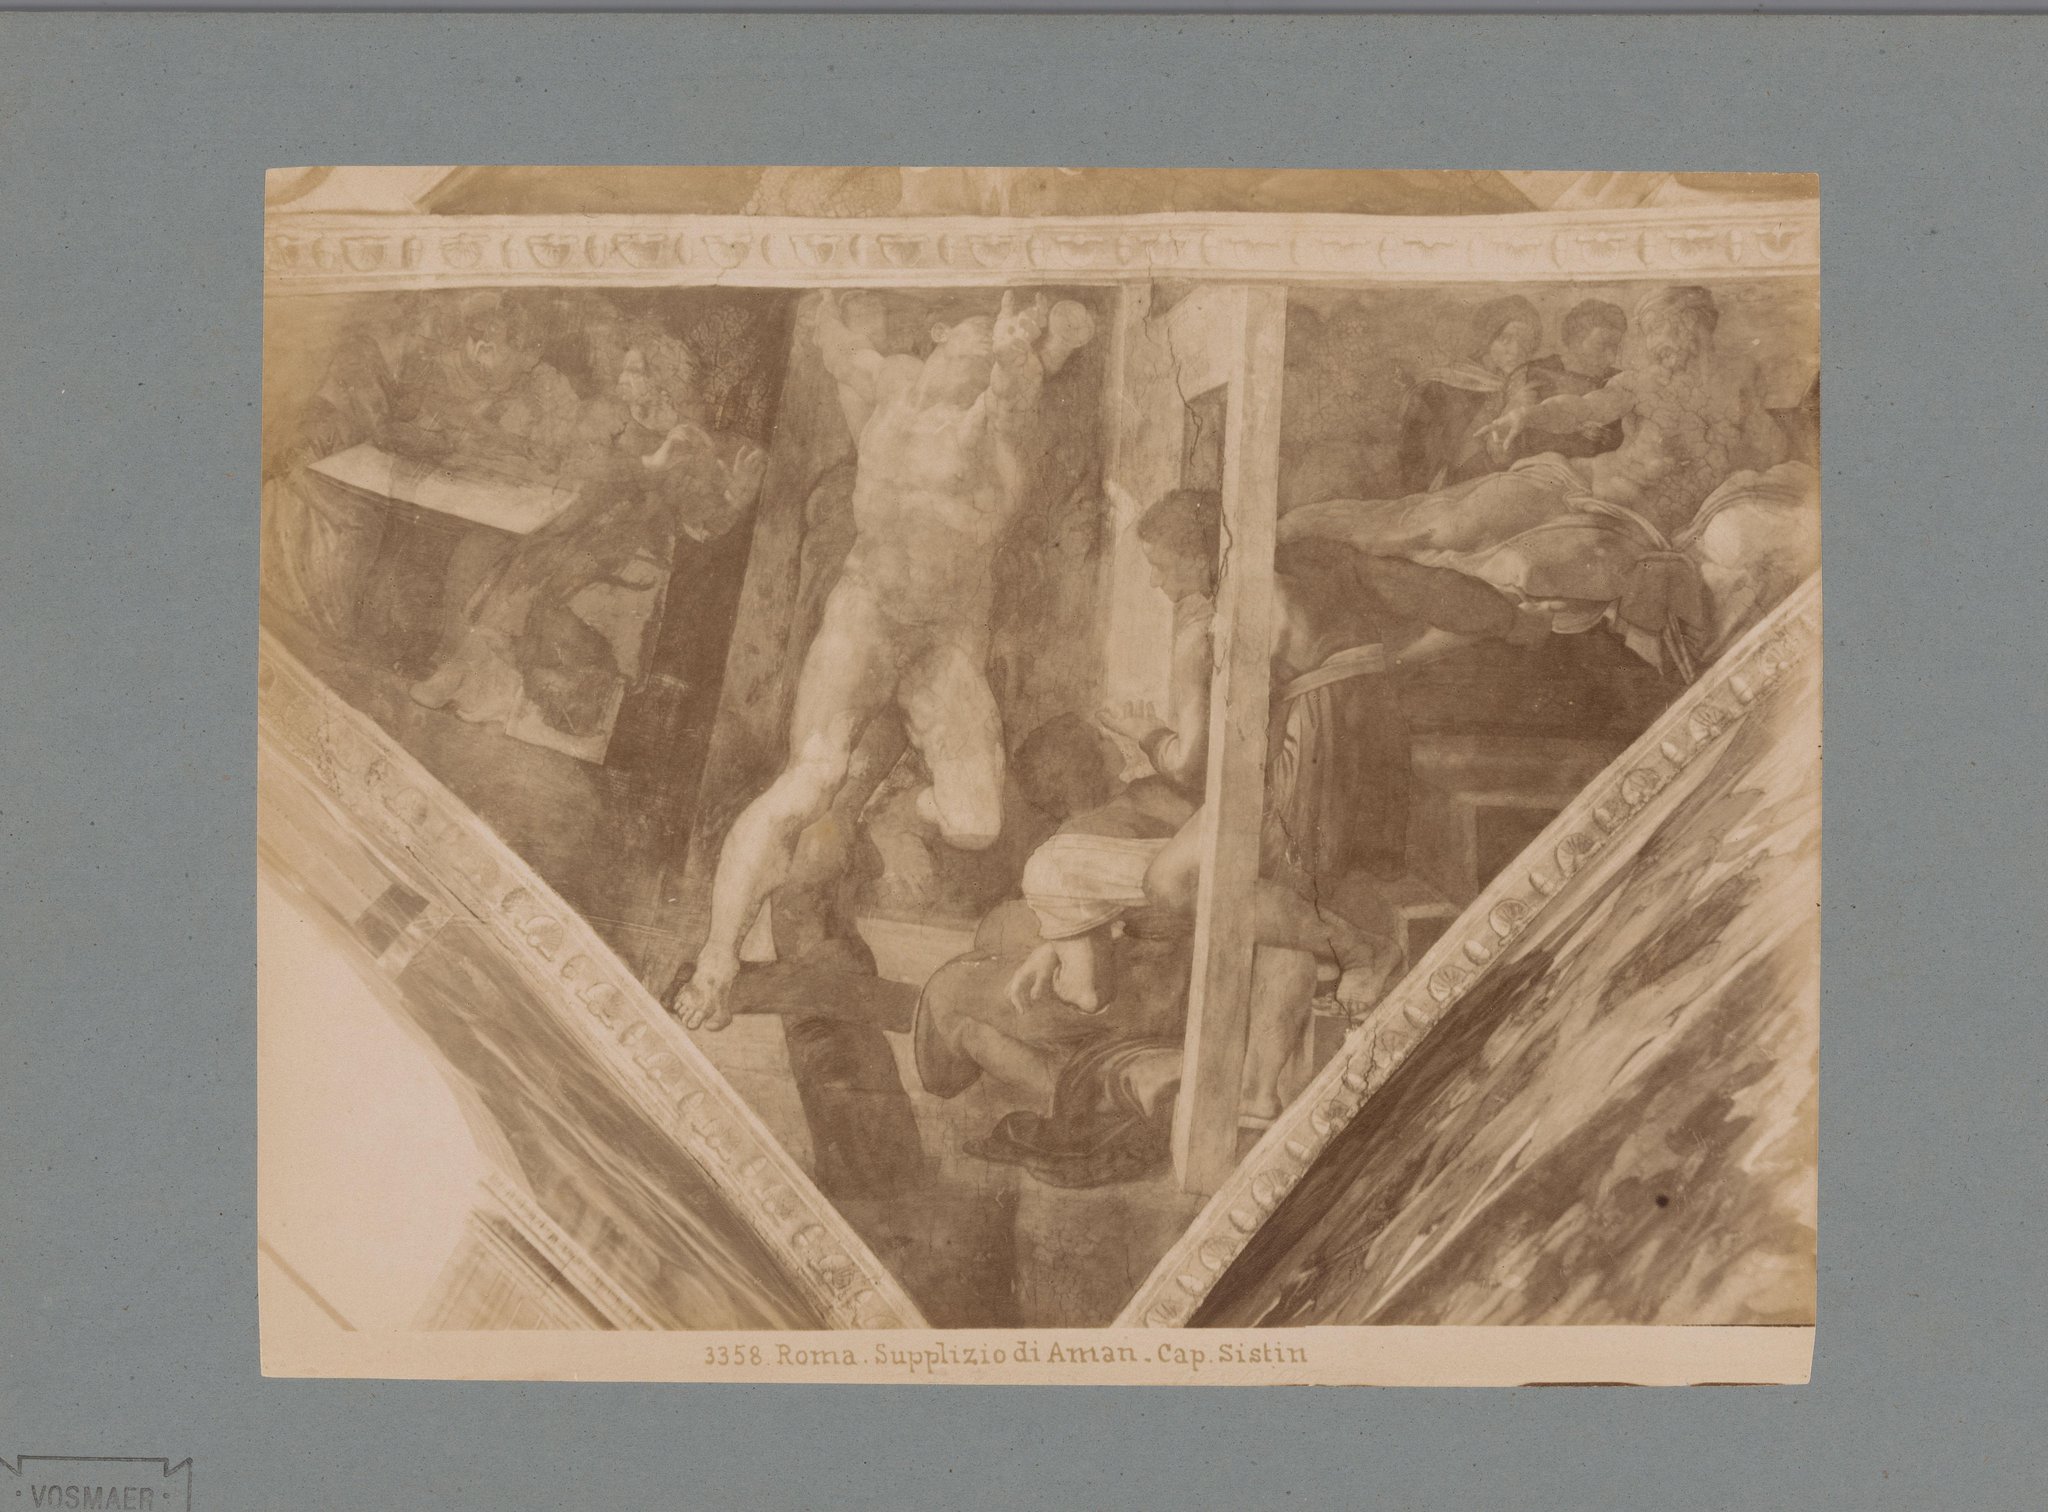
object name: photograph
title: Fotoreproductie van het fresco Het ophangen van Haman door Michelangelo in de Sixtijnse kapel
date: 1851-1900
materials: cardboard, paper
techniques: albumen print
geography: vatican city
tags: picture, painting, wall-covering, haman on the gallows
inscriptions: number: ‘3358.’, collector's mark: ‘VOSMAER’